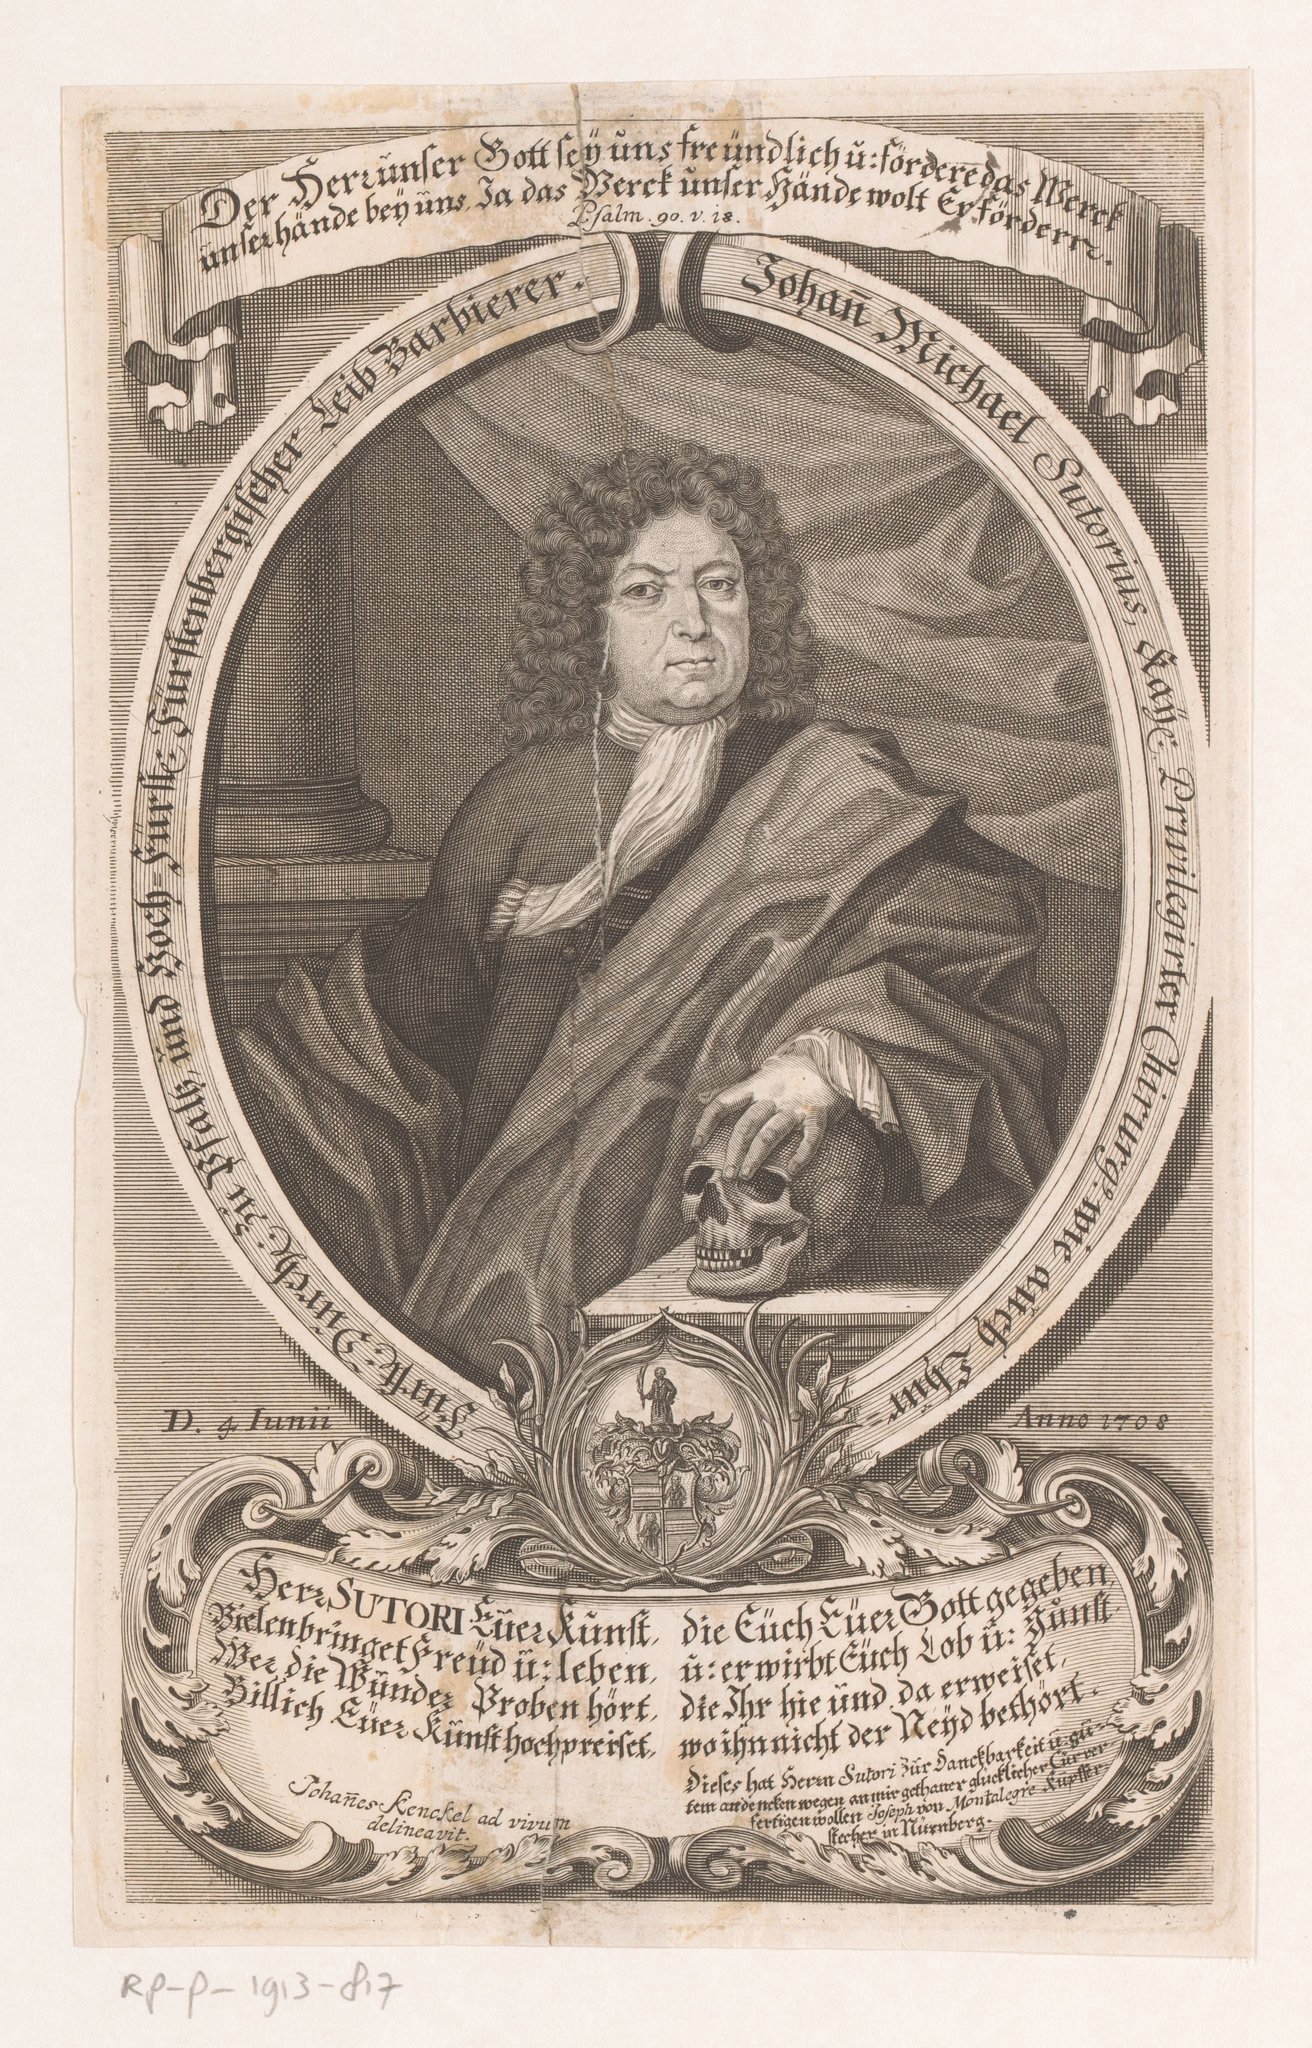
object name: print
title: Portret van Franz Gotthold Delmuc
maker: matthias van sommer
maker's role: draughtsman, print maker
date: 1668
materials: paper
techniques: engraving, etching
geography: germany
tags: politician, historical persons, armorial bearing, heraldry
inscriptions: collector's mark: Lugt 2228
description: Volgens Hollstein werd de prent gebruikt voor de publicatie: Sommer, Matthias van. Hasce Omnium Electorum. Regensburg: s.n., 1667. Alhoewel op de titelpagina van de publicatie het jaar 1667 wordt vermeld, zijn meerdere prenten later gedateerd. Waarschijnlijk werd de publicatie pas in 1671 daadwerkelijk uitgegeven.